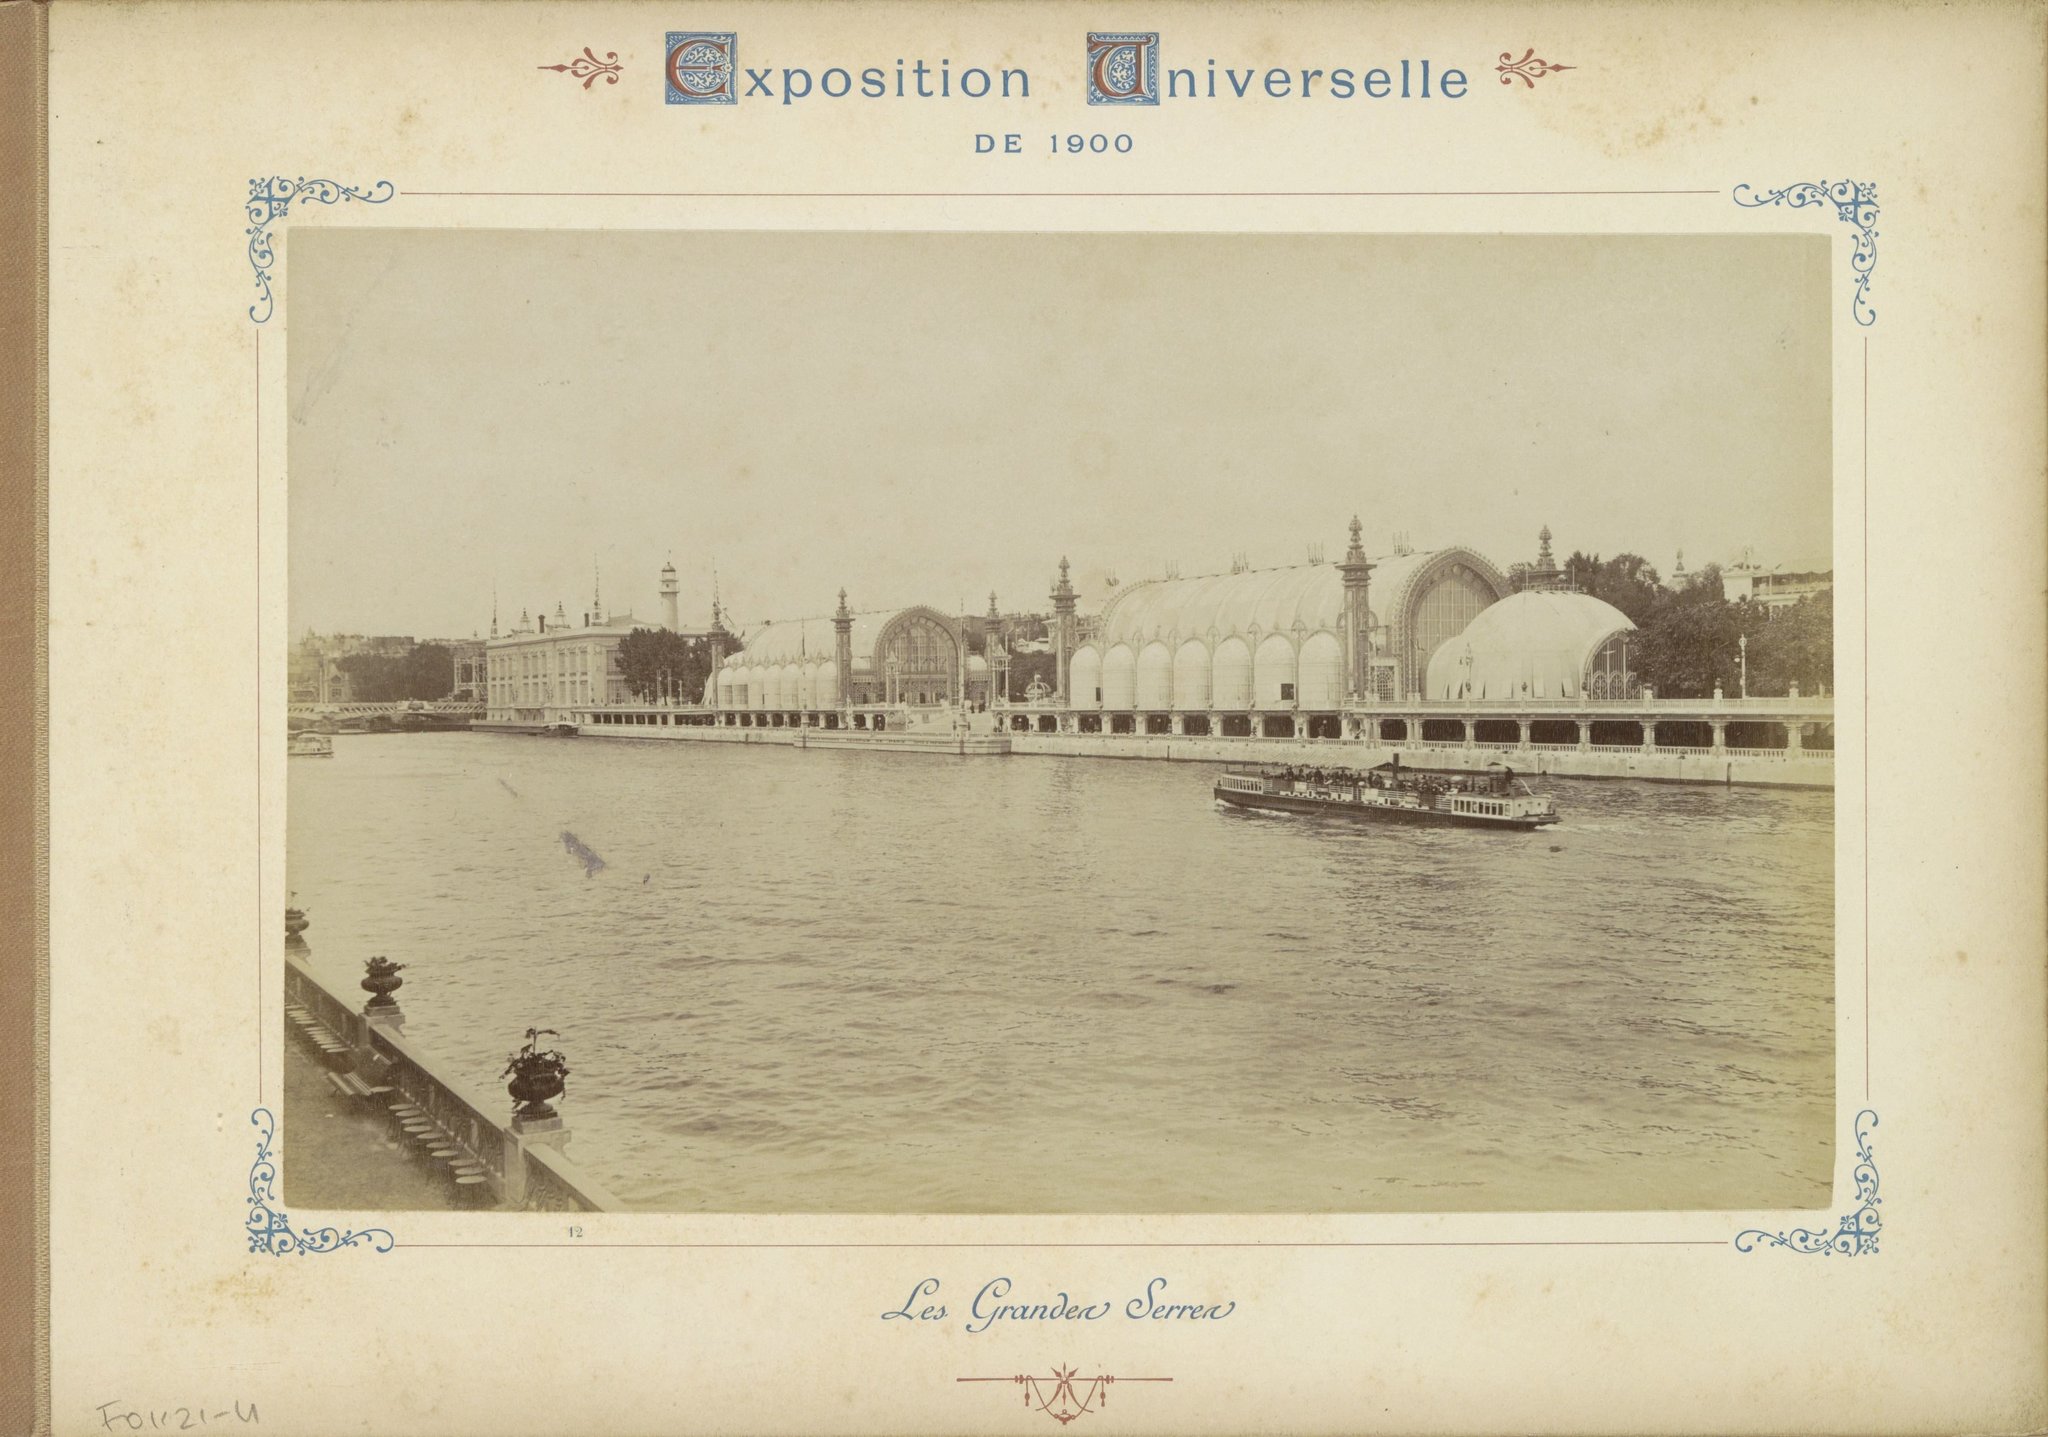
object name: photograph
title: Gezicht op de serres van het Palais de l'Horticulture langs de Seine in Parijs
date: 1900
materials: cardboard, paper, photographic support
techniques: albumen print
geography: paris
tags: world fair, world exhibition, palace, greenhouse, orangery, quay (+ city(-scape) with figures, staffage), steamship, motorship, paris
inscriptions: number: ‘12’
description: Onderdeel van Fotoalbum met opnames van de Wereldtentoonstelling van 1900 in Parijs.